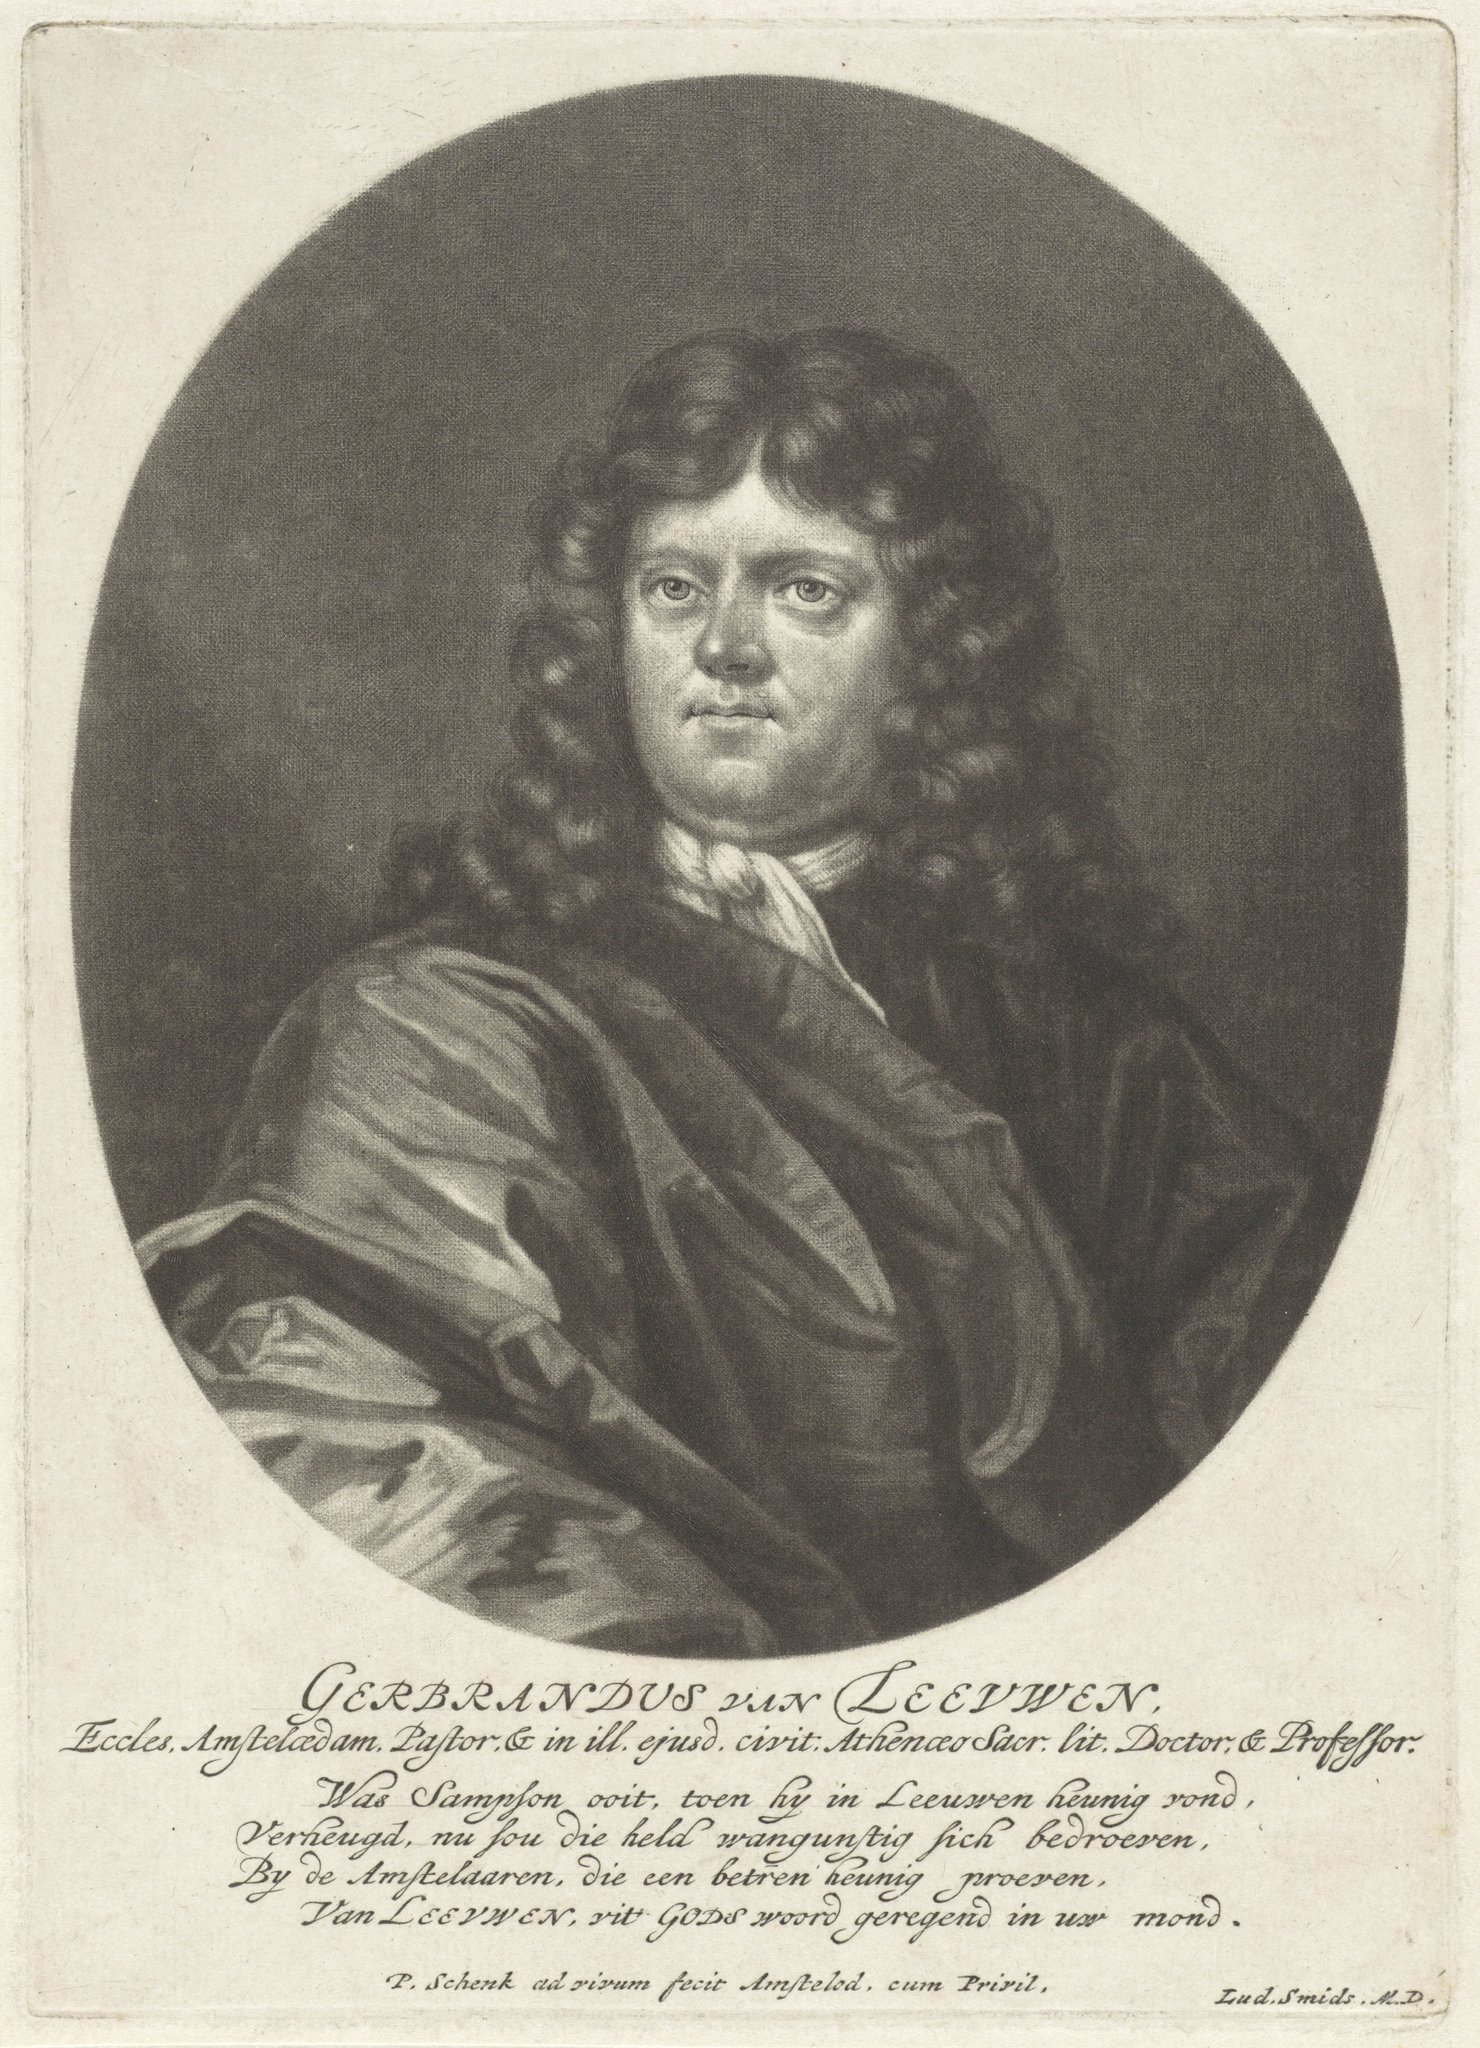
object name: print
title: Portret van Gerbrand van Leeuwen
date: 1670-1713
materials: paper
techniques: engraving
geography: amsterdam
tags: hoogleraar, gerbrand van leeuwen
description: De predikant en hoogleraar Gerbrand van Leeuwen.